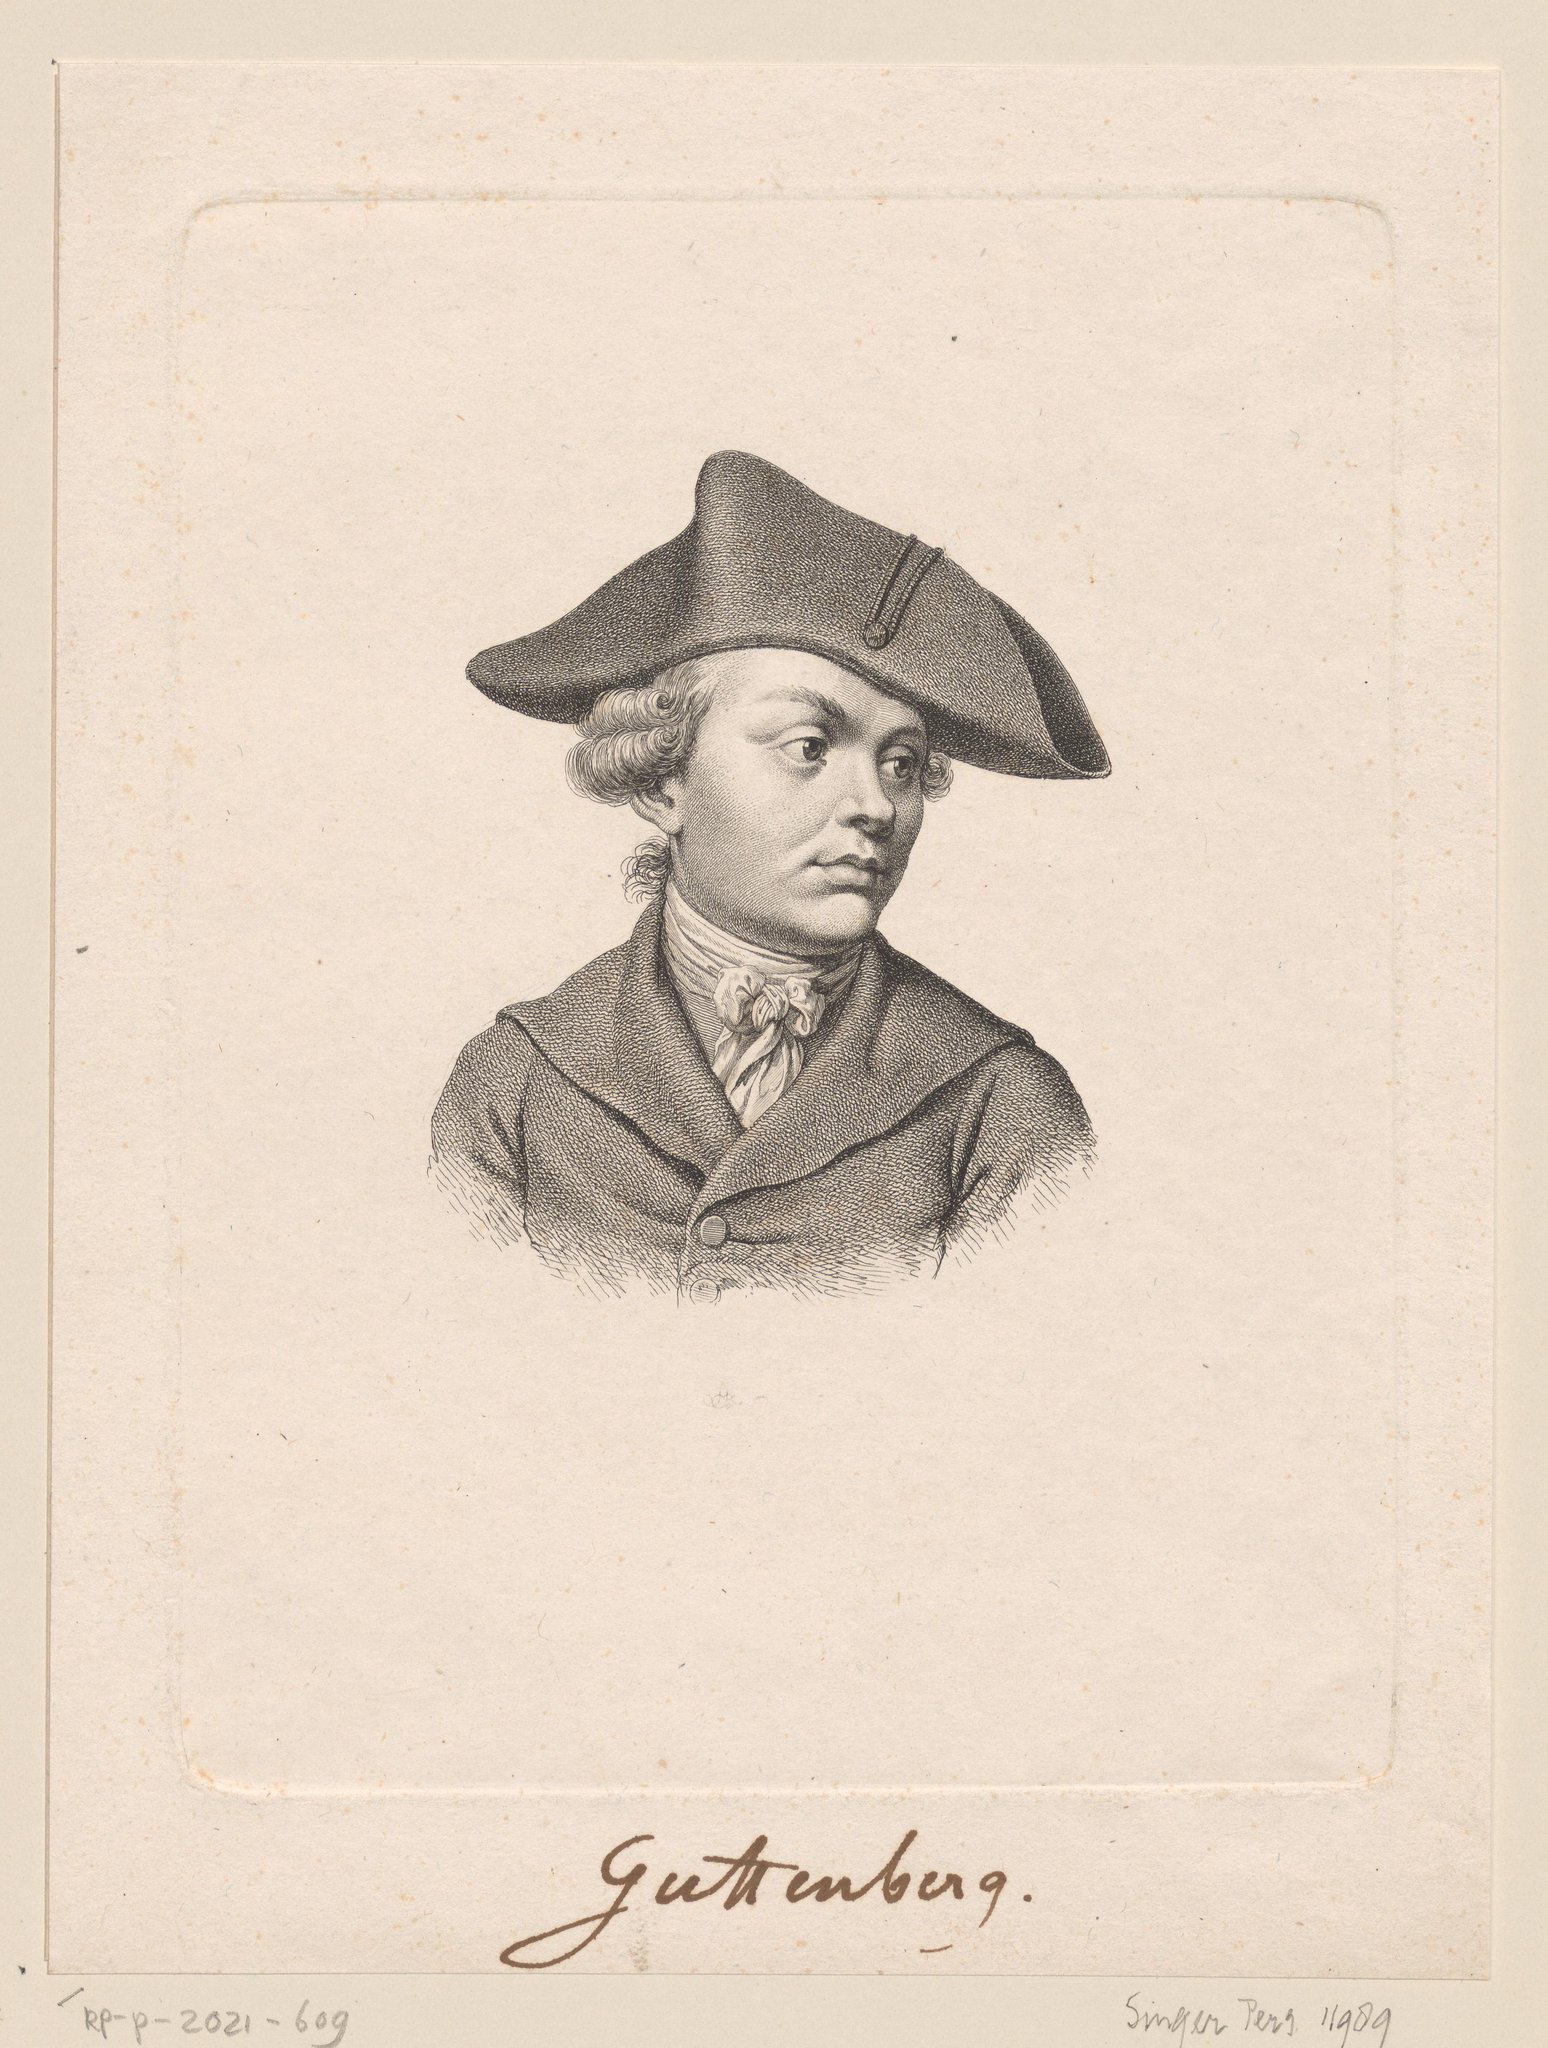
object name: print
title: Portret van Heinrich Guttenberg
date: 1801-1834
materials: paper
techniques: engraving, etching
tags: heinrich guttenberg, historical persons, portrait, self-portrait of graphic artist